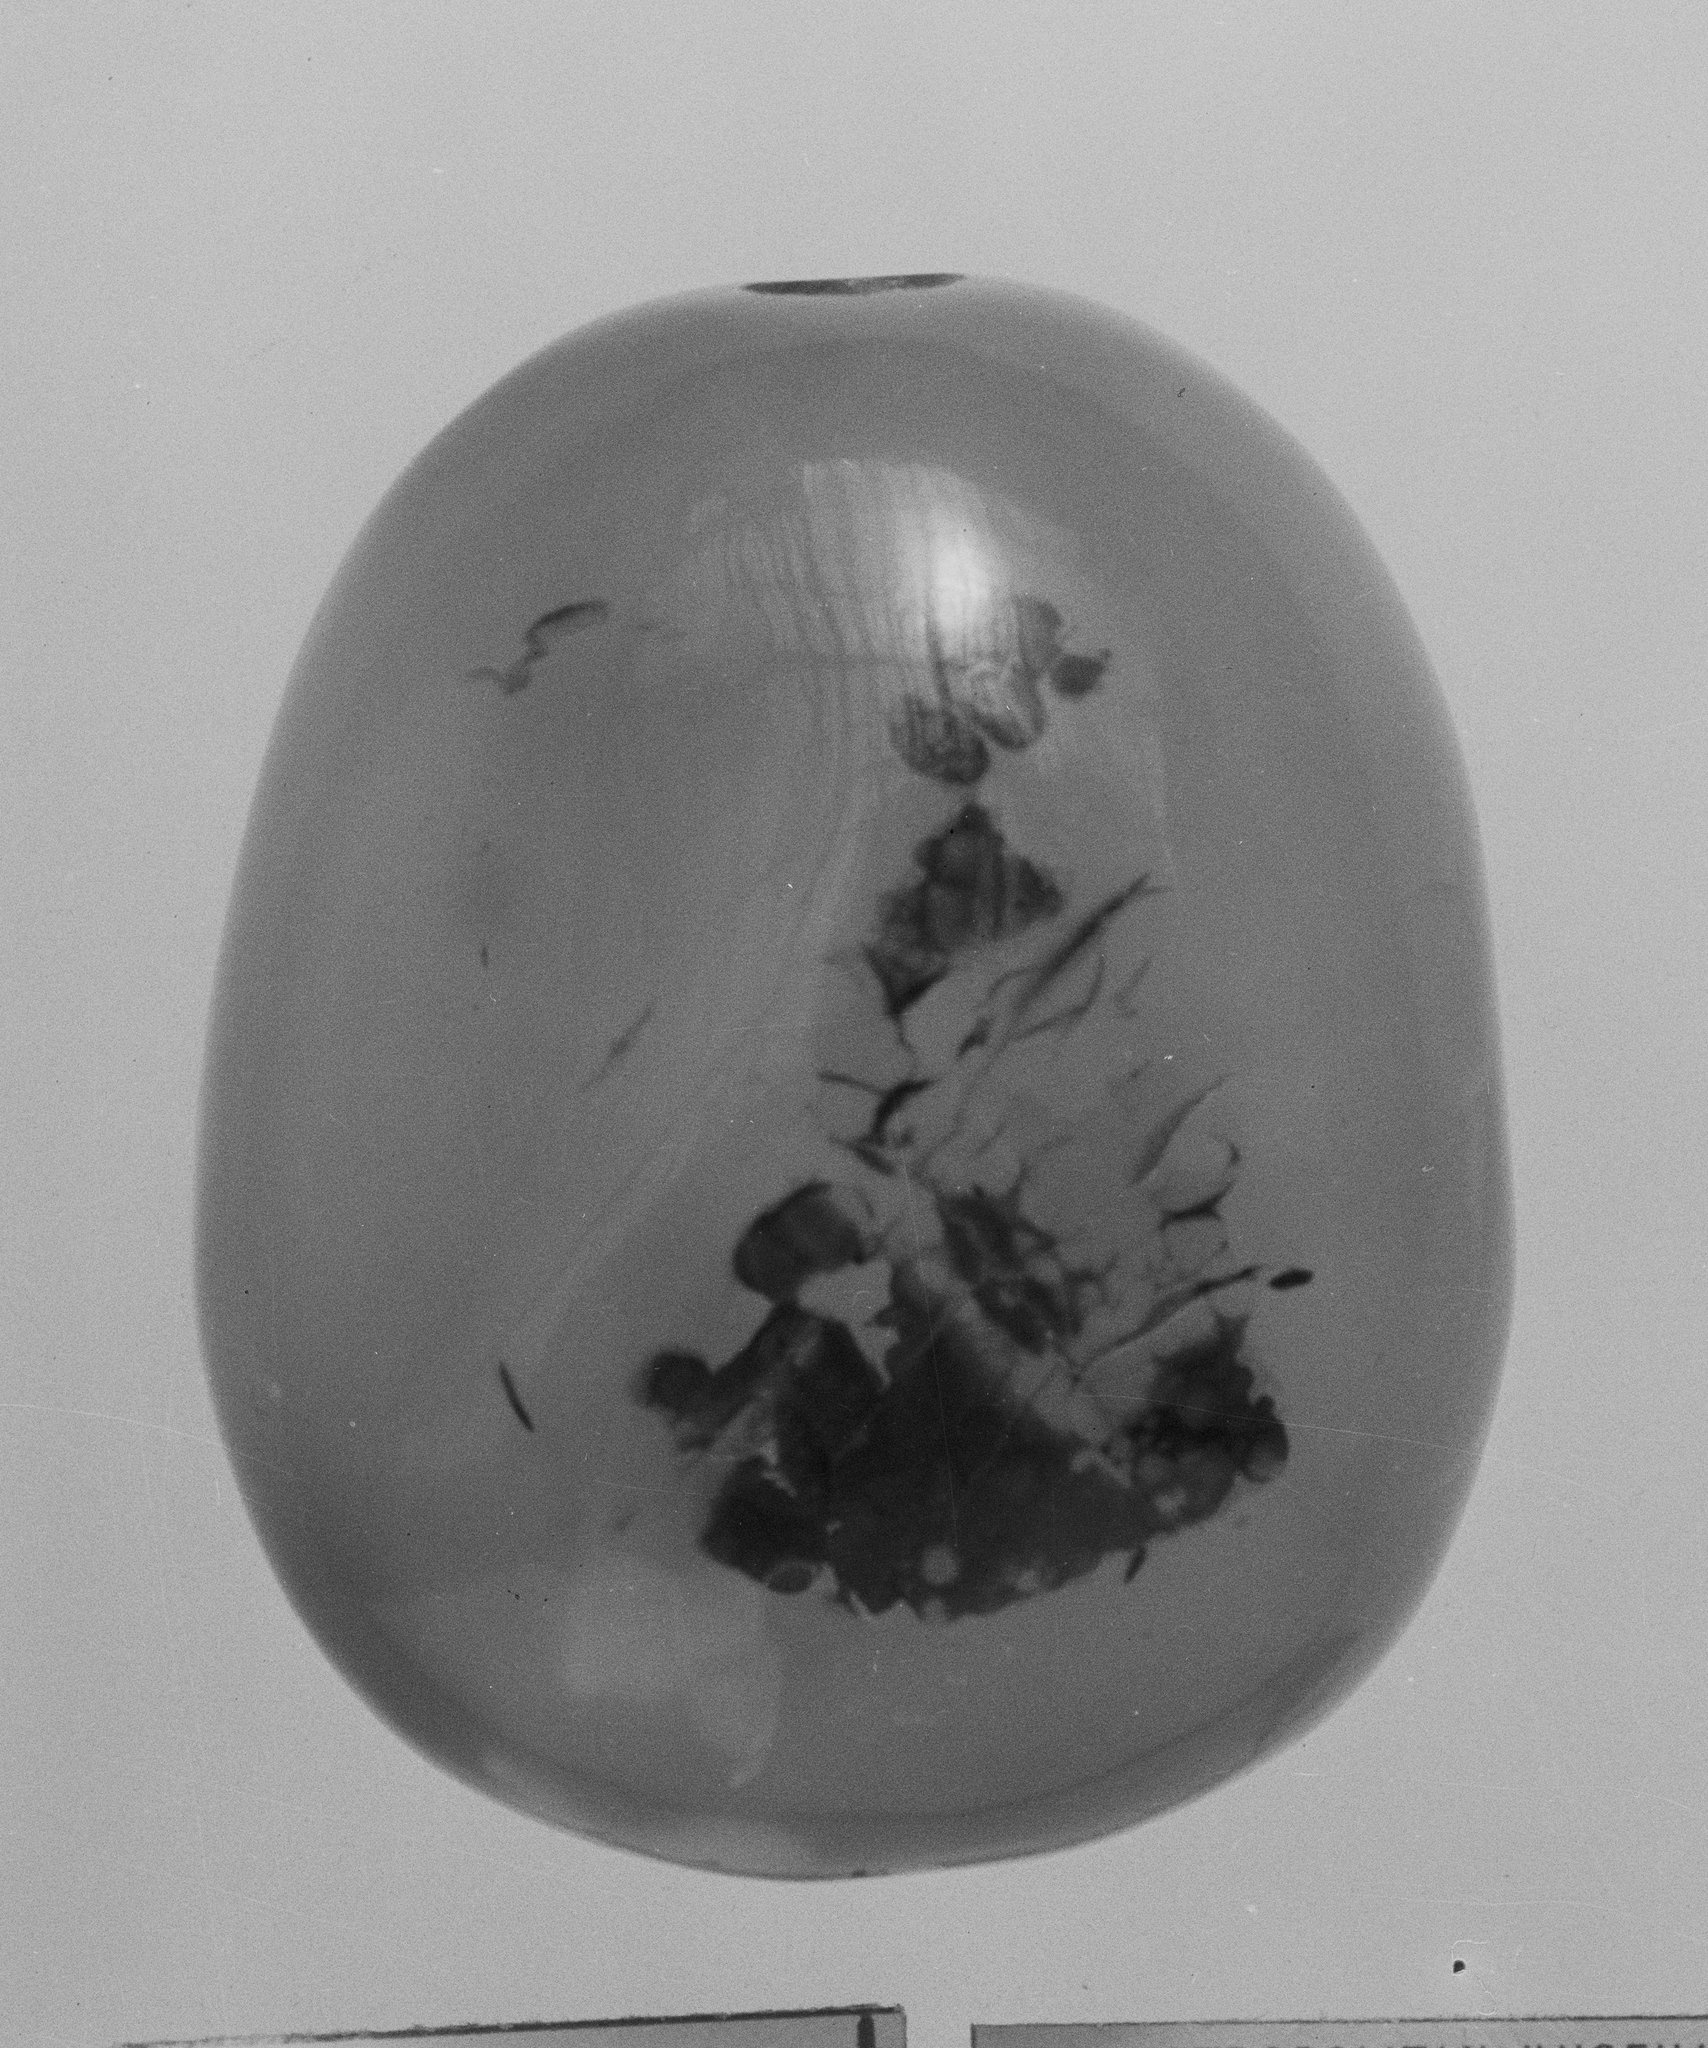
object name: snuff bottle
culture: chinese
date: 1701-1900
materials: stone